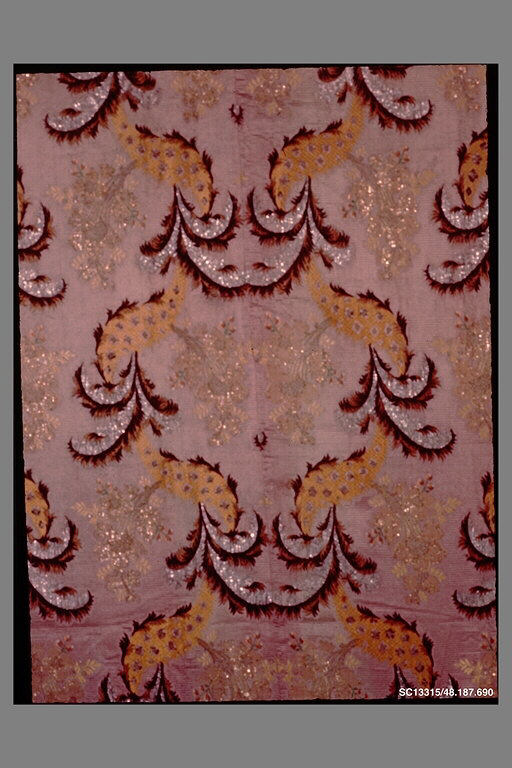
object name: piece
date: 1750-1760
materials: metal thread, silk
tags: flowers